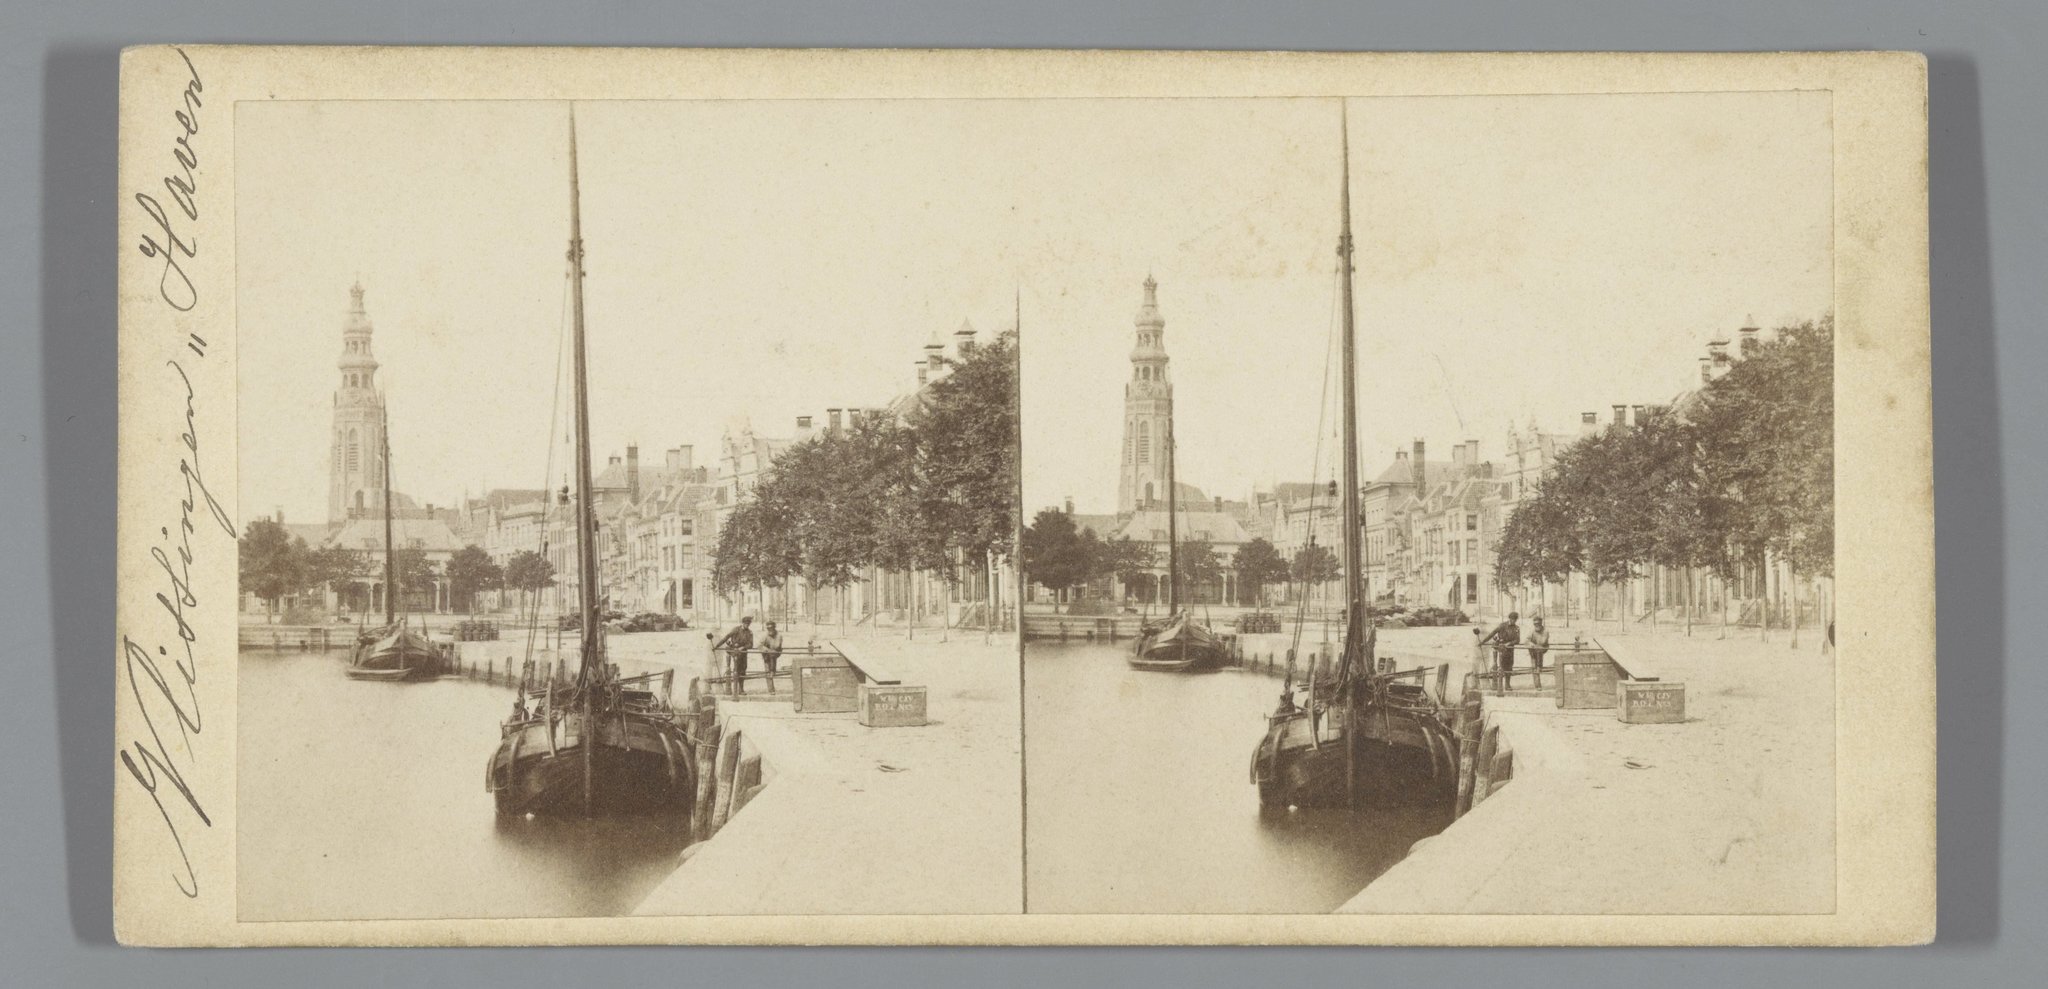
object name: stereograph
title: Vlissingen, haven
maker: pieter oosterhuis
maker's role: draughtsman, print maker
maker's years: 1816-1885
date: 1865-1870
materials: cardboard, paper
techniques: albumen print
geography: middelburg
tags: harbour, middelburg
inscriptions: inscription: ‘Vlissingen,/ Haven’, number: ‘No. 1’, inscription: ‘P.’, number: ‘34’, number: ‘1’, inscription: ‘= Middelburg (MB)’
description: In tegenstelling tot het opschrift gaat het hier niet om Vlissingen maar om Middelburg.